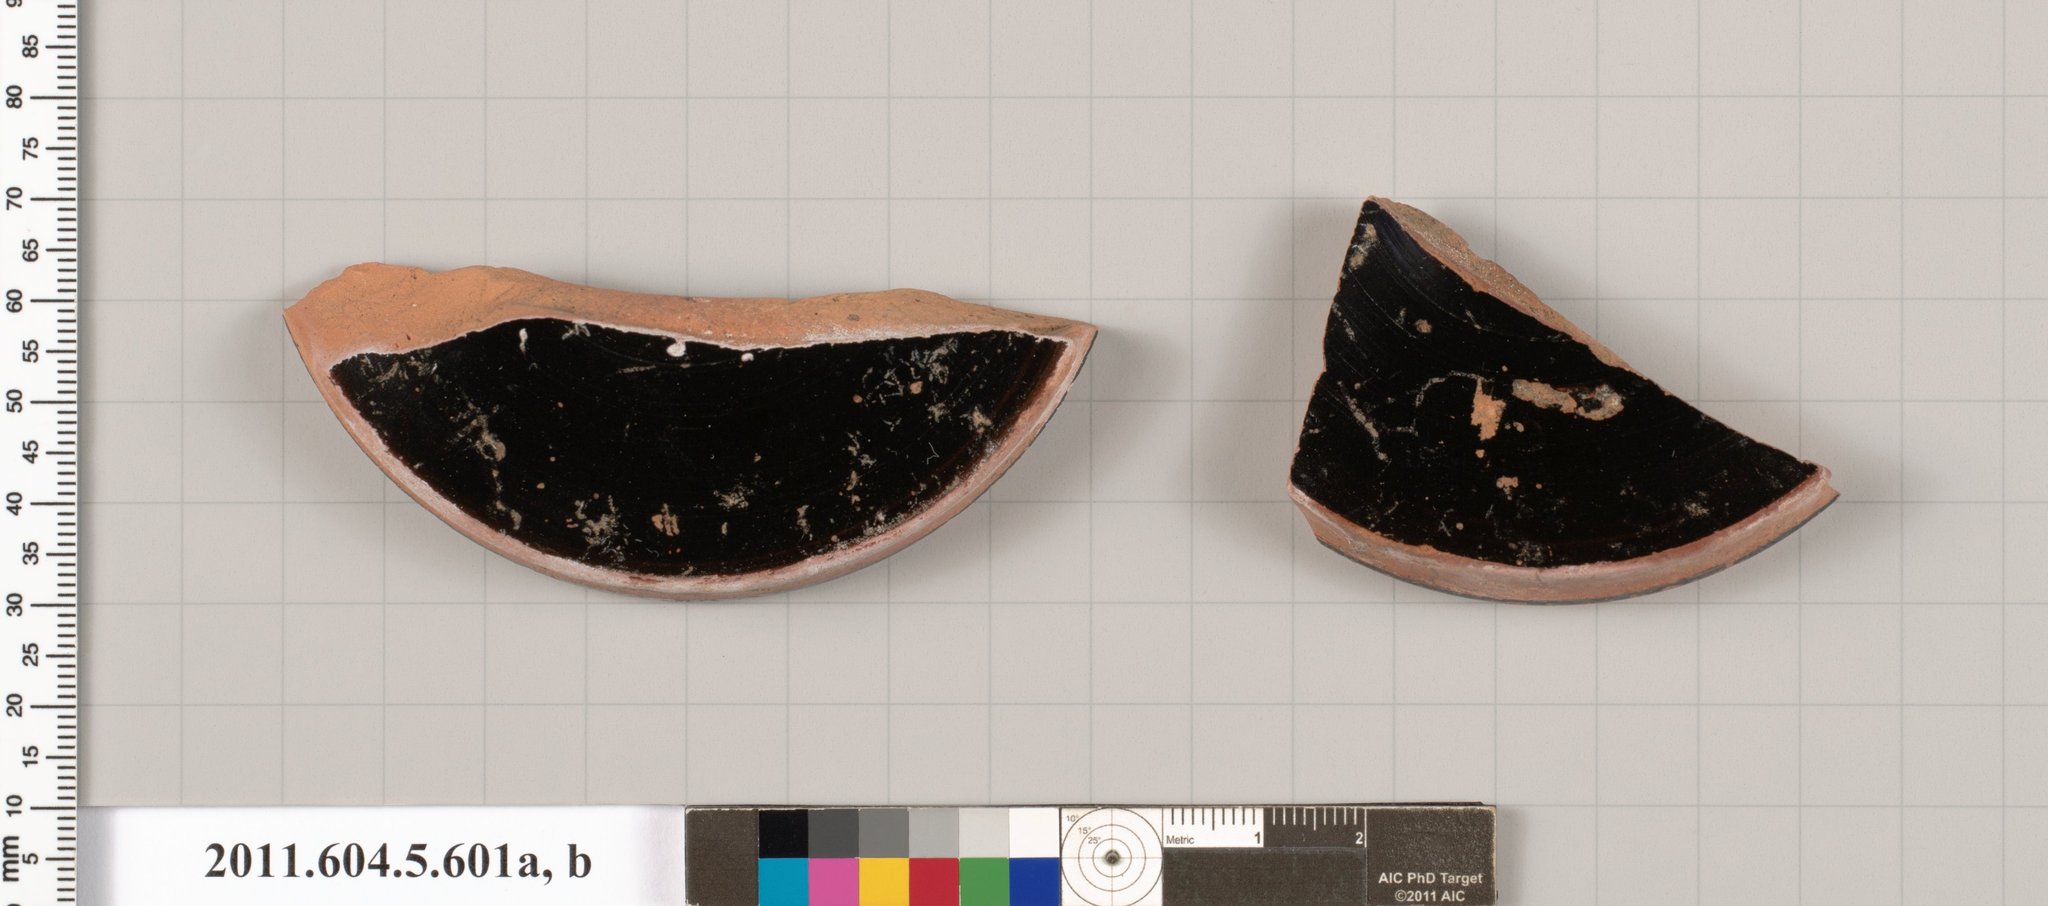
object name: kylix fragment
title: Terracotta fragments of a kylix (drinking cup)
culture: greek, attic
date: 600-401 BCE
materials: terracotta